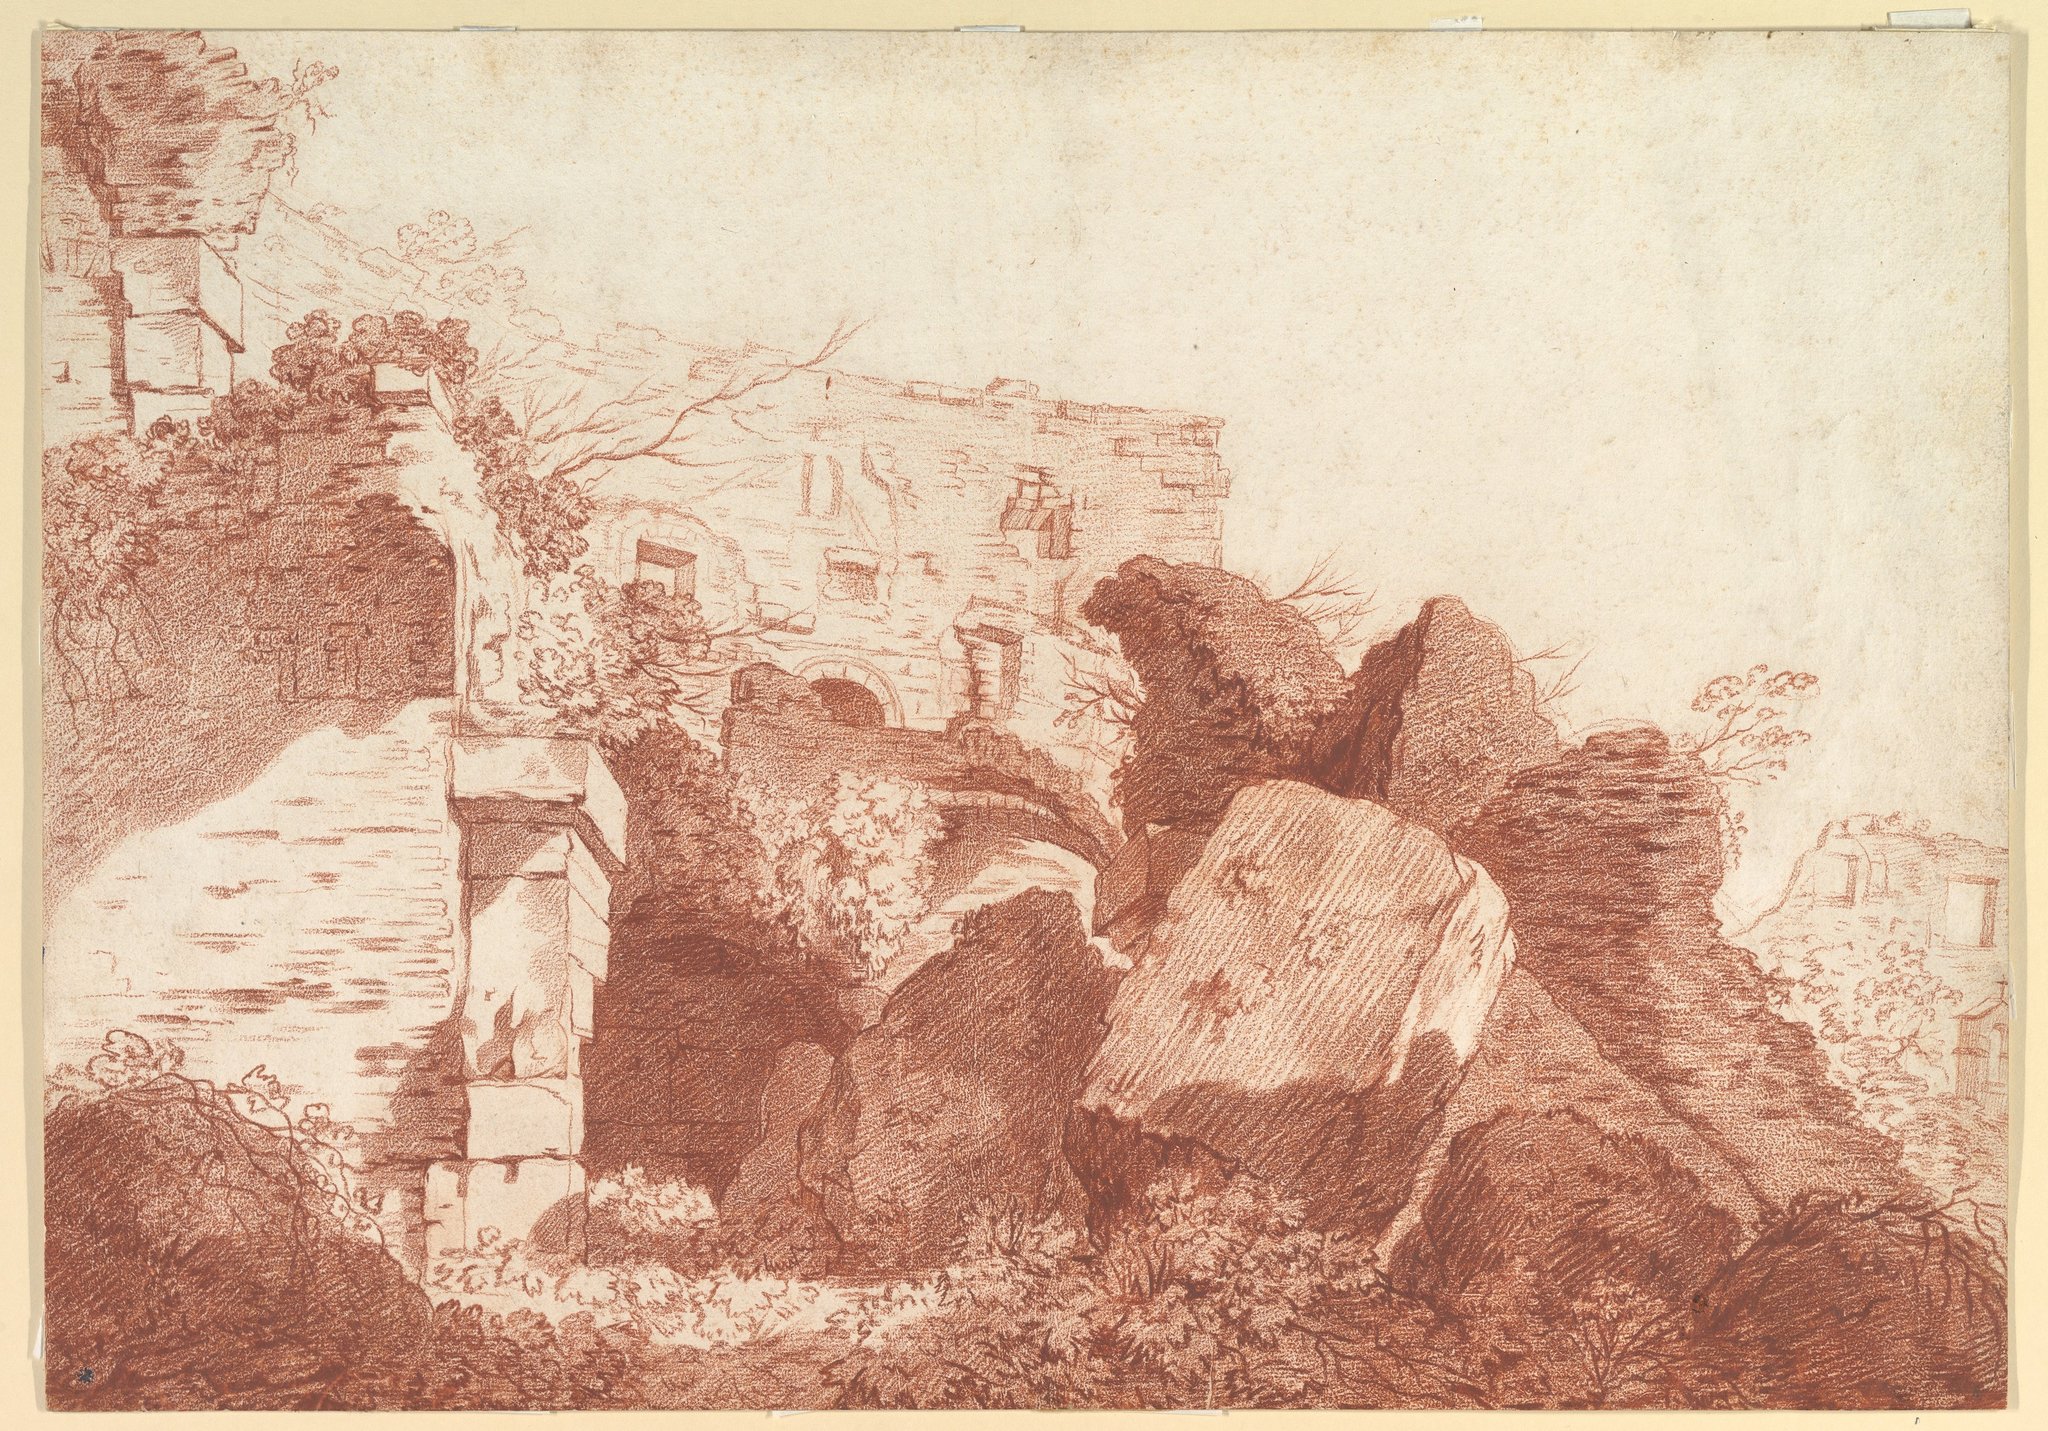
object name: drawing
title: Ruins of the Palatine Hill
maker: joseph benoît suvée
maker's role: artist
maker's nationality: french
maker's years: 1743-1807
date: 1772-1776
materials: chalk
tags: ruins